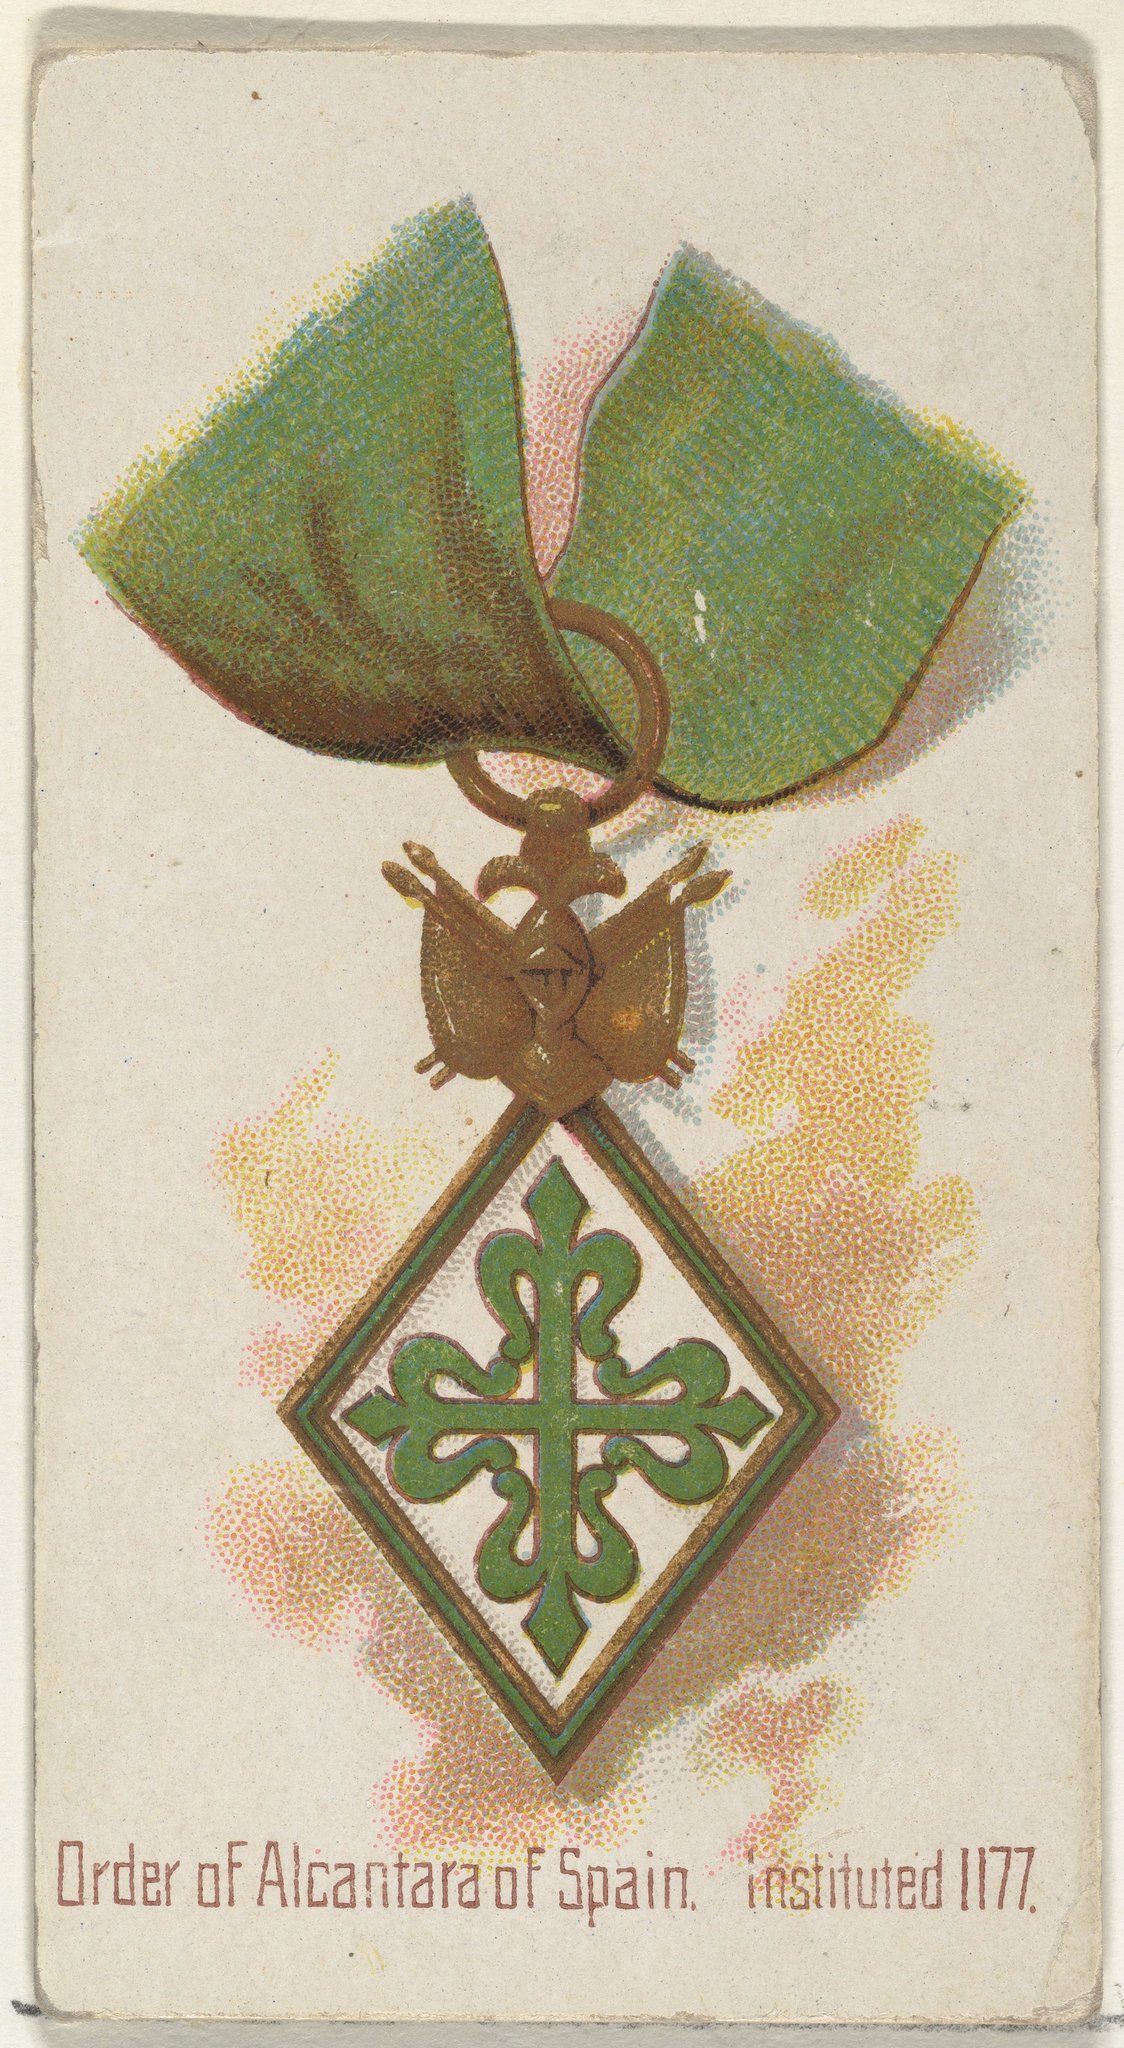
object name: print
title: Order of Alcantara of Spain, Instituted 1177, from the World's Decorations series (N30) for Allen & Ginter Cigarettes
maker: allen & ginter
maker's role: publisher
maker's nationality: american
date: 1890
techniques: color lithograph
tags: medals